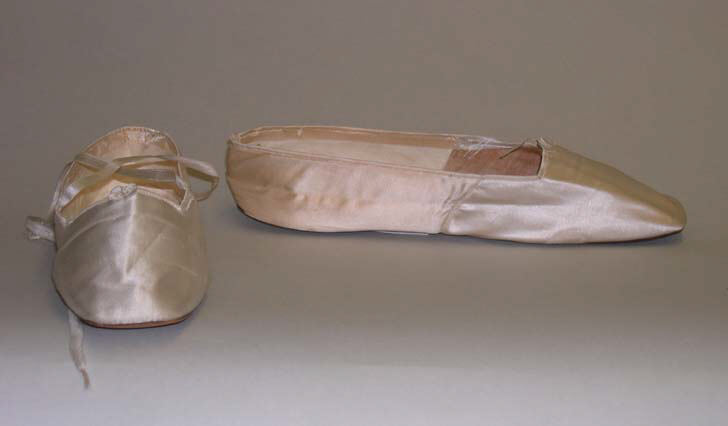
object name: shoe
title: Shoes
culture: french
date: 1835-1849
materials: leather, silk